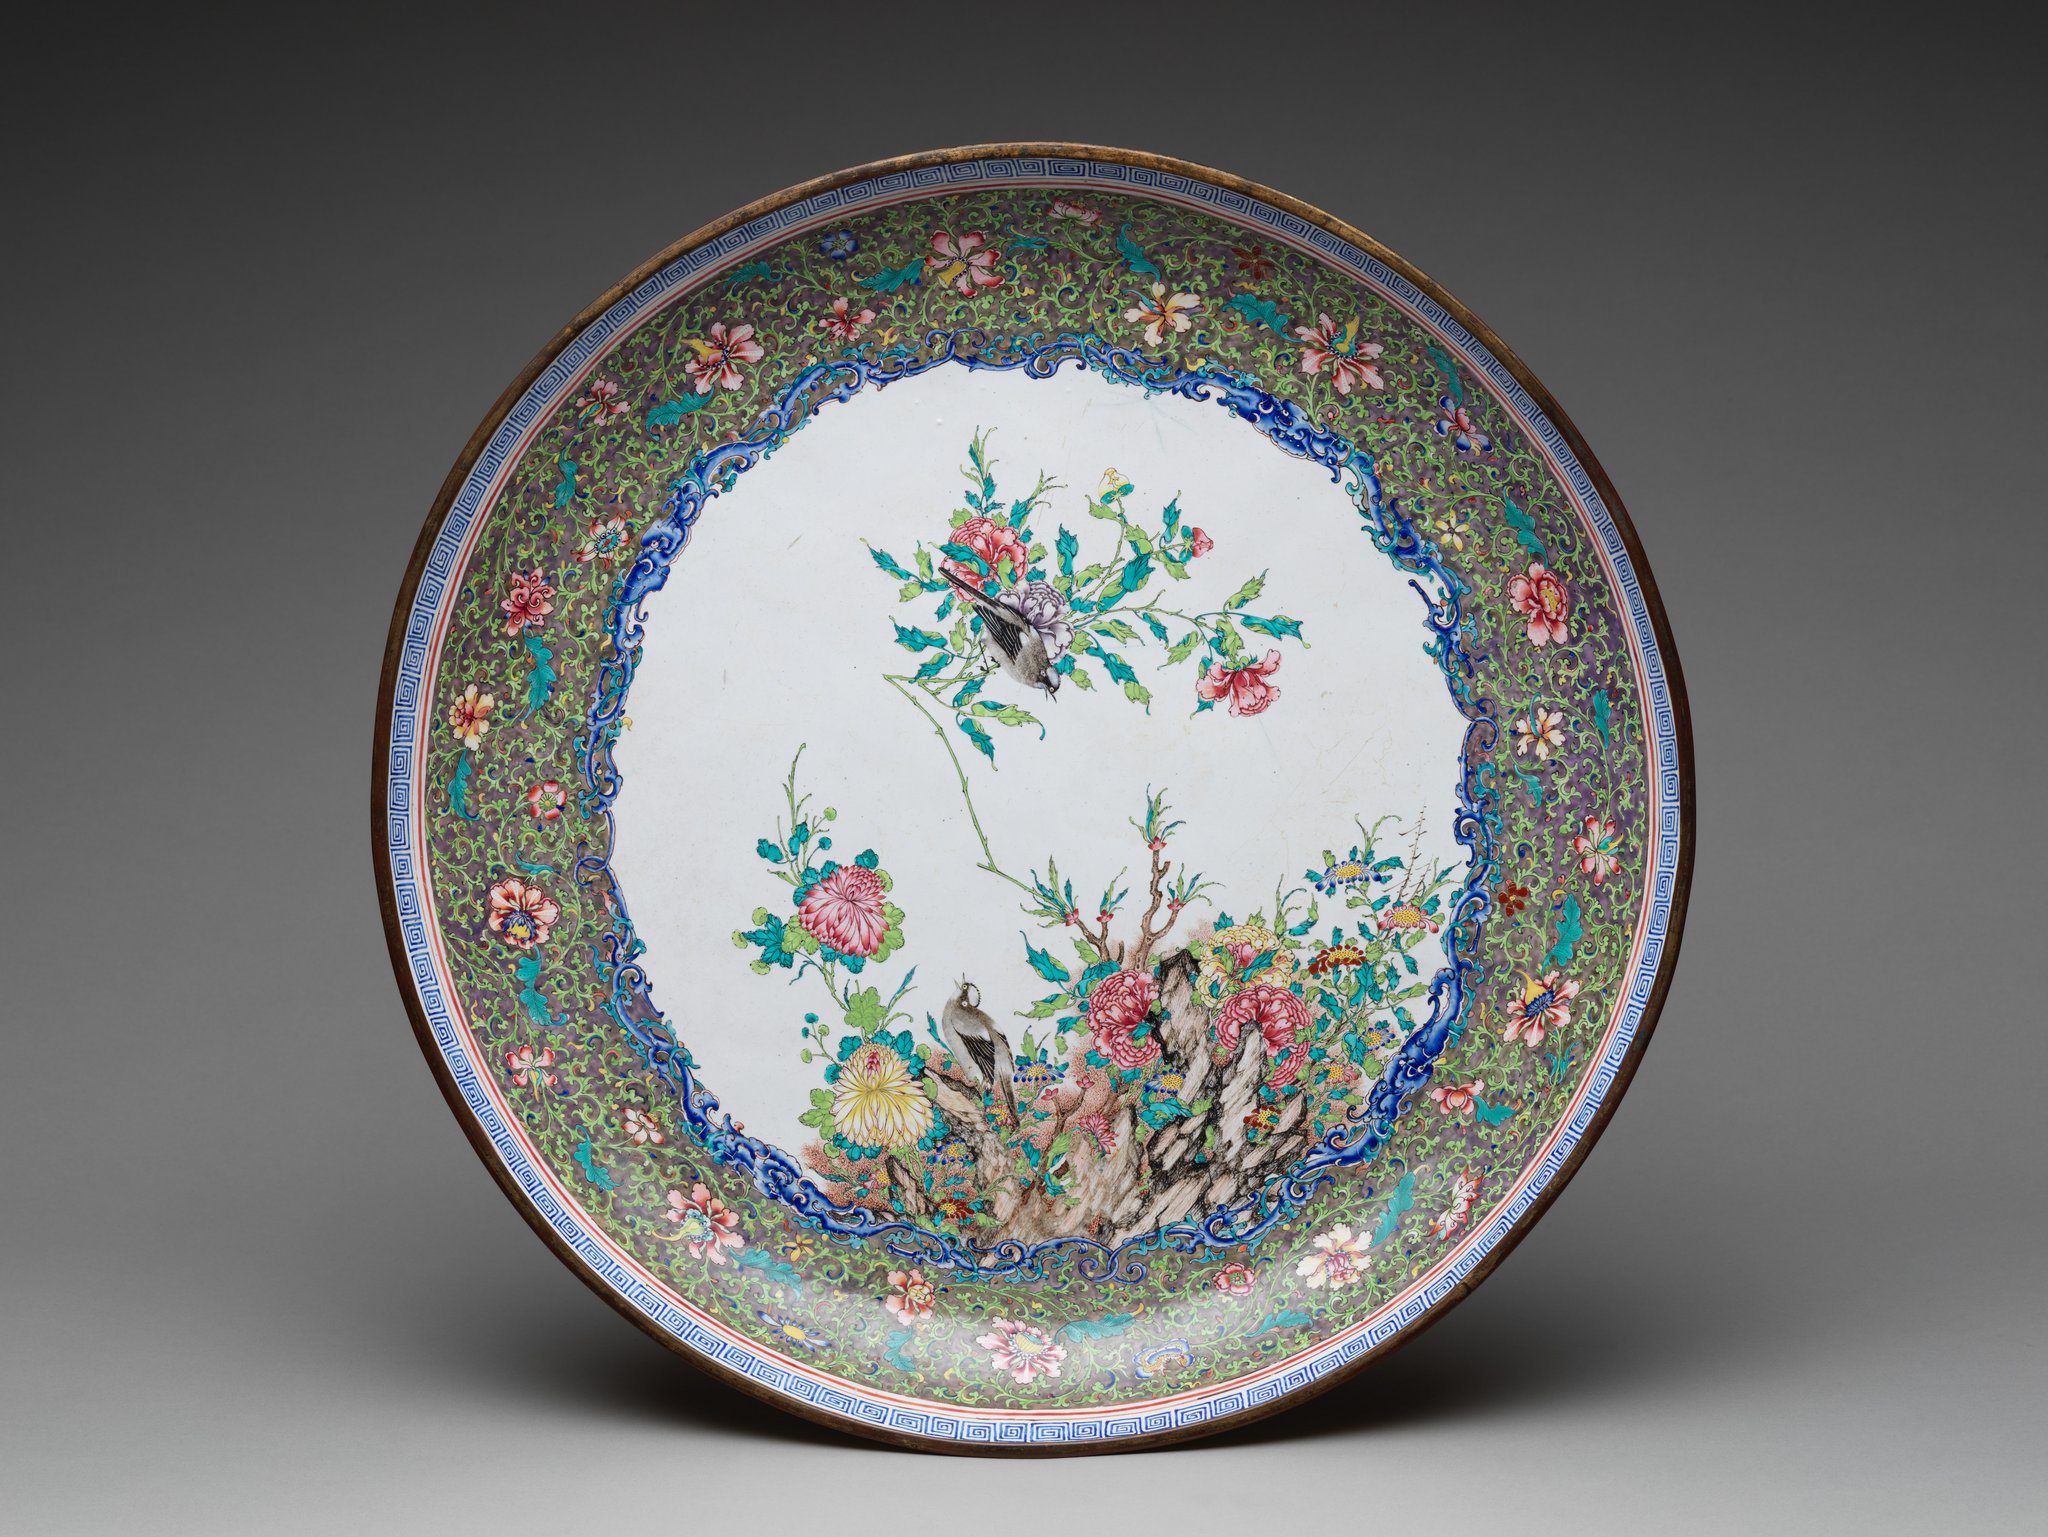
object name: plate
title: Plate with birds and flowers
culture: chinese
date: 1734-1766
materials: copper alloy, enamel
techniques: painting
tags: birds,flowers